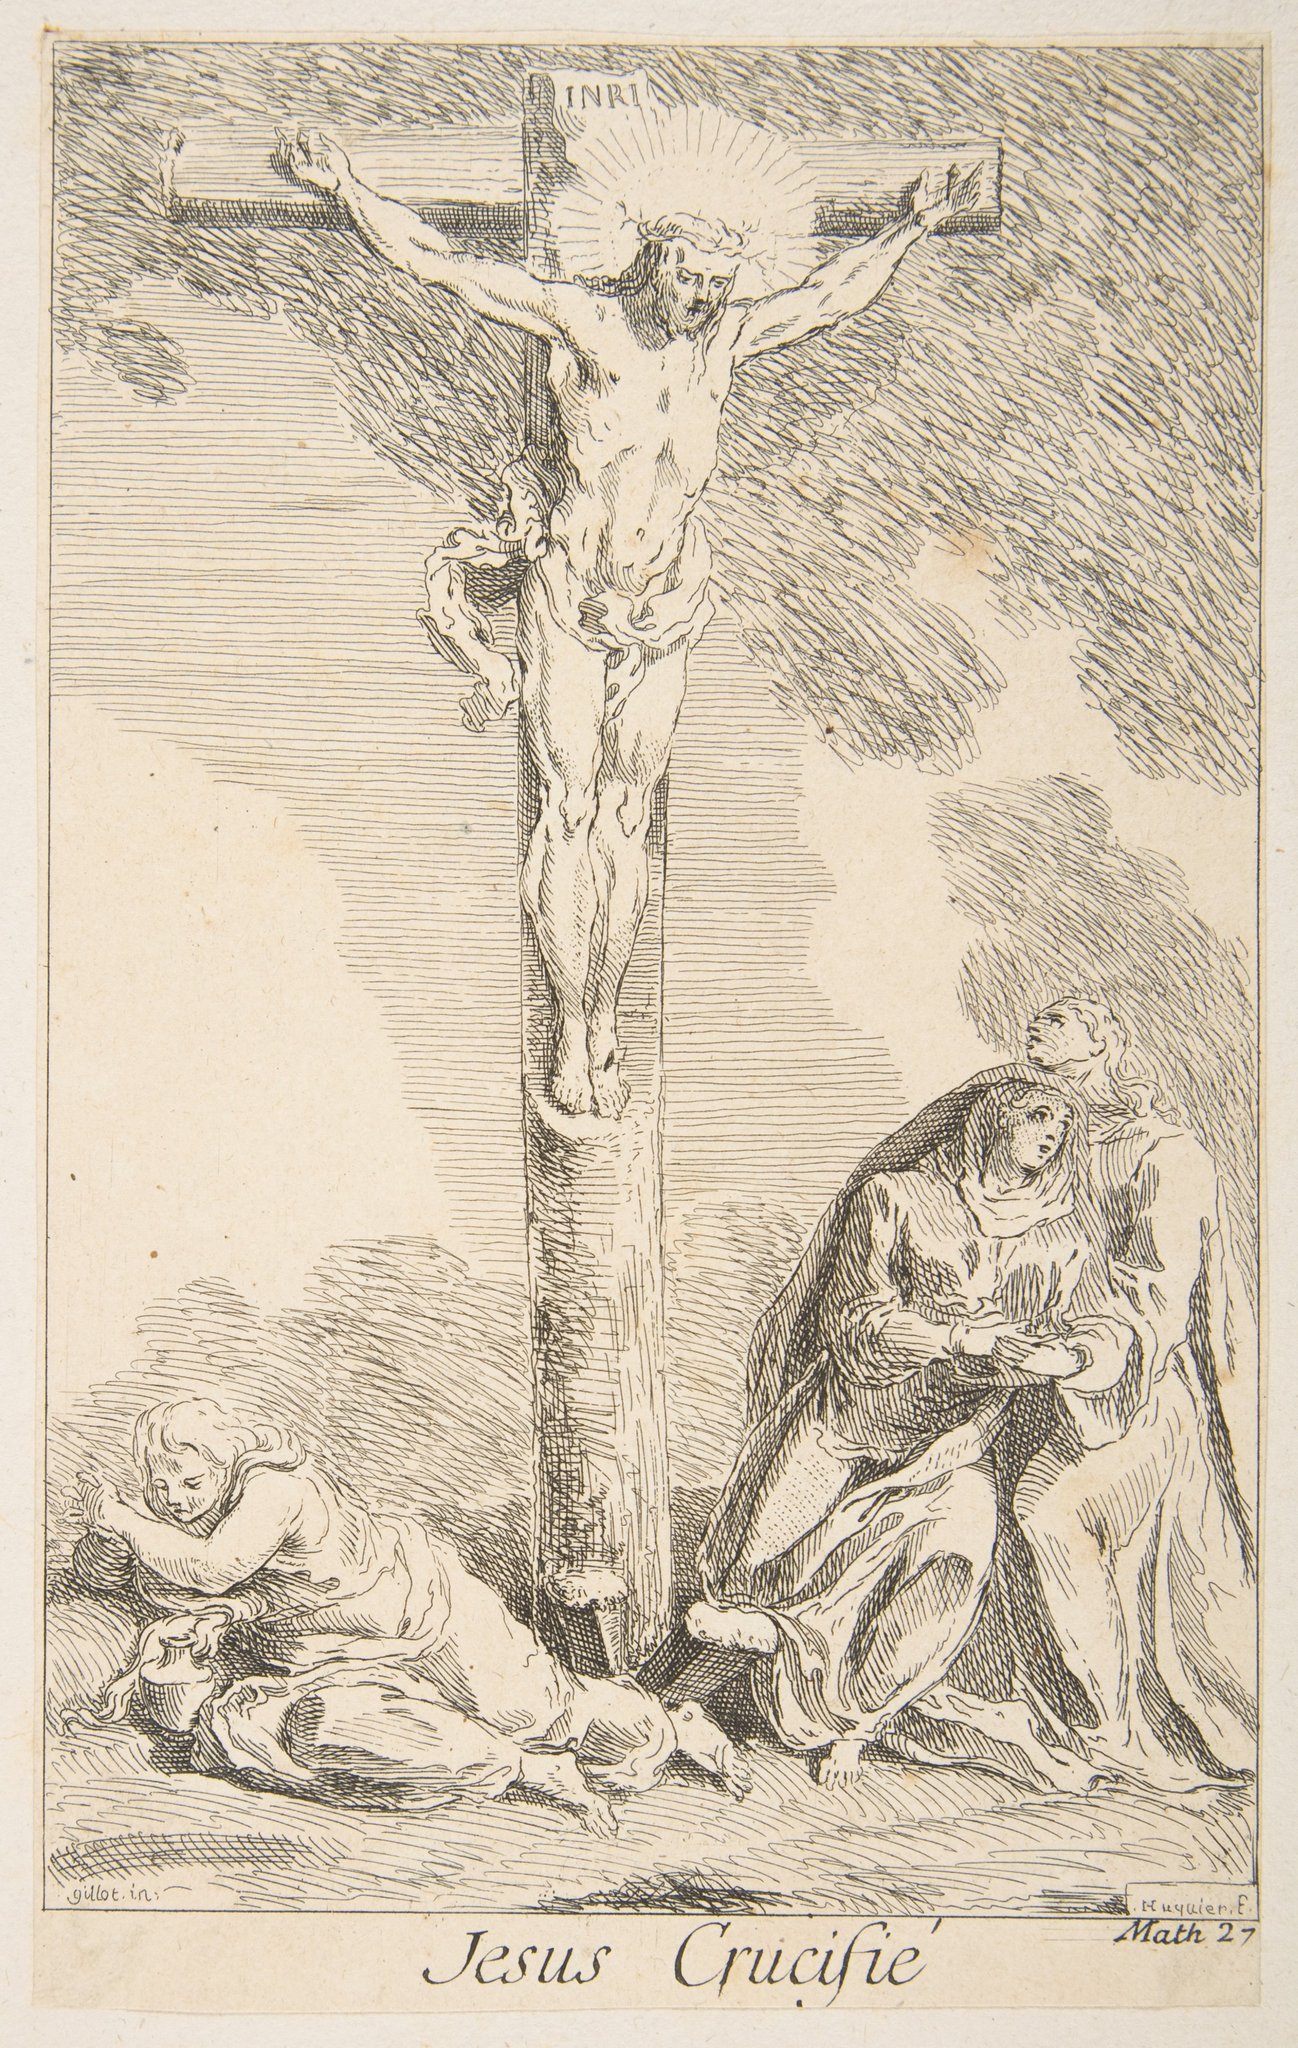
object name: print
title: Crucifixion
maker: claude gillot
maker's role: artist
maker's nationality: french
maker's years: 1673-1722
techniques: etching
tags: men,women,jesus,crucifixion